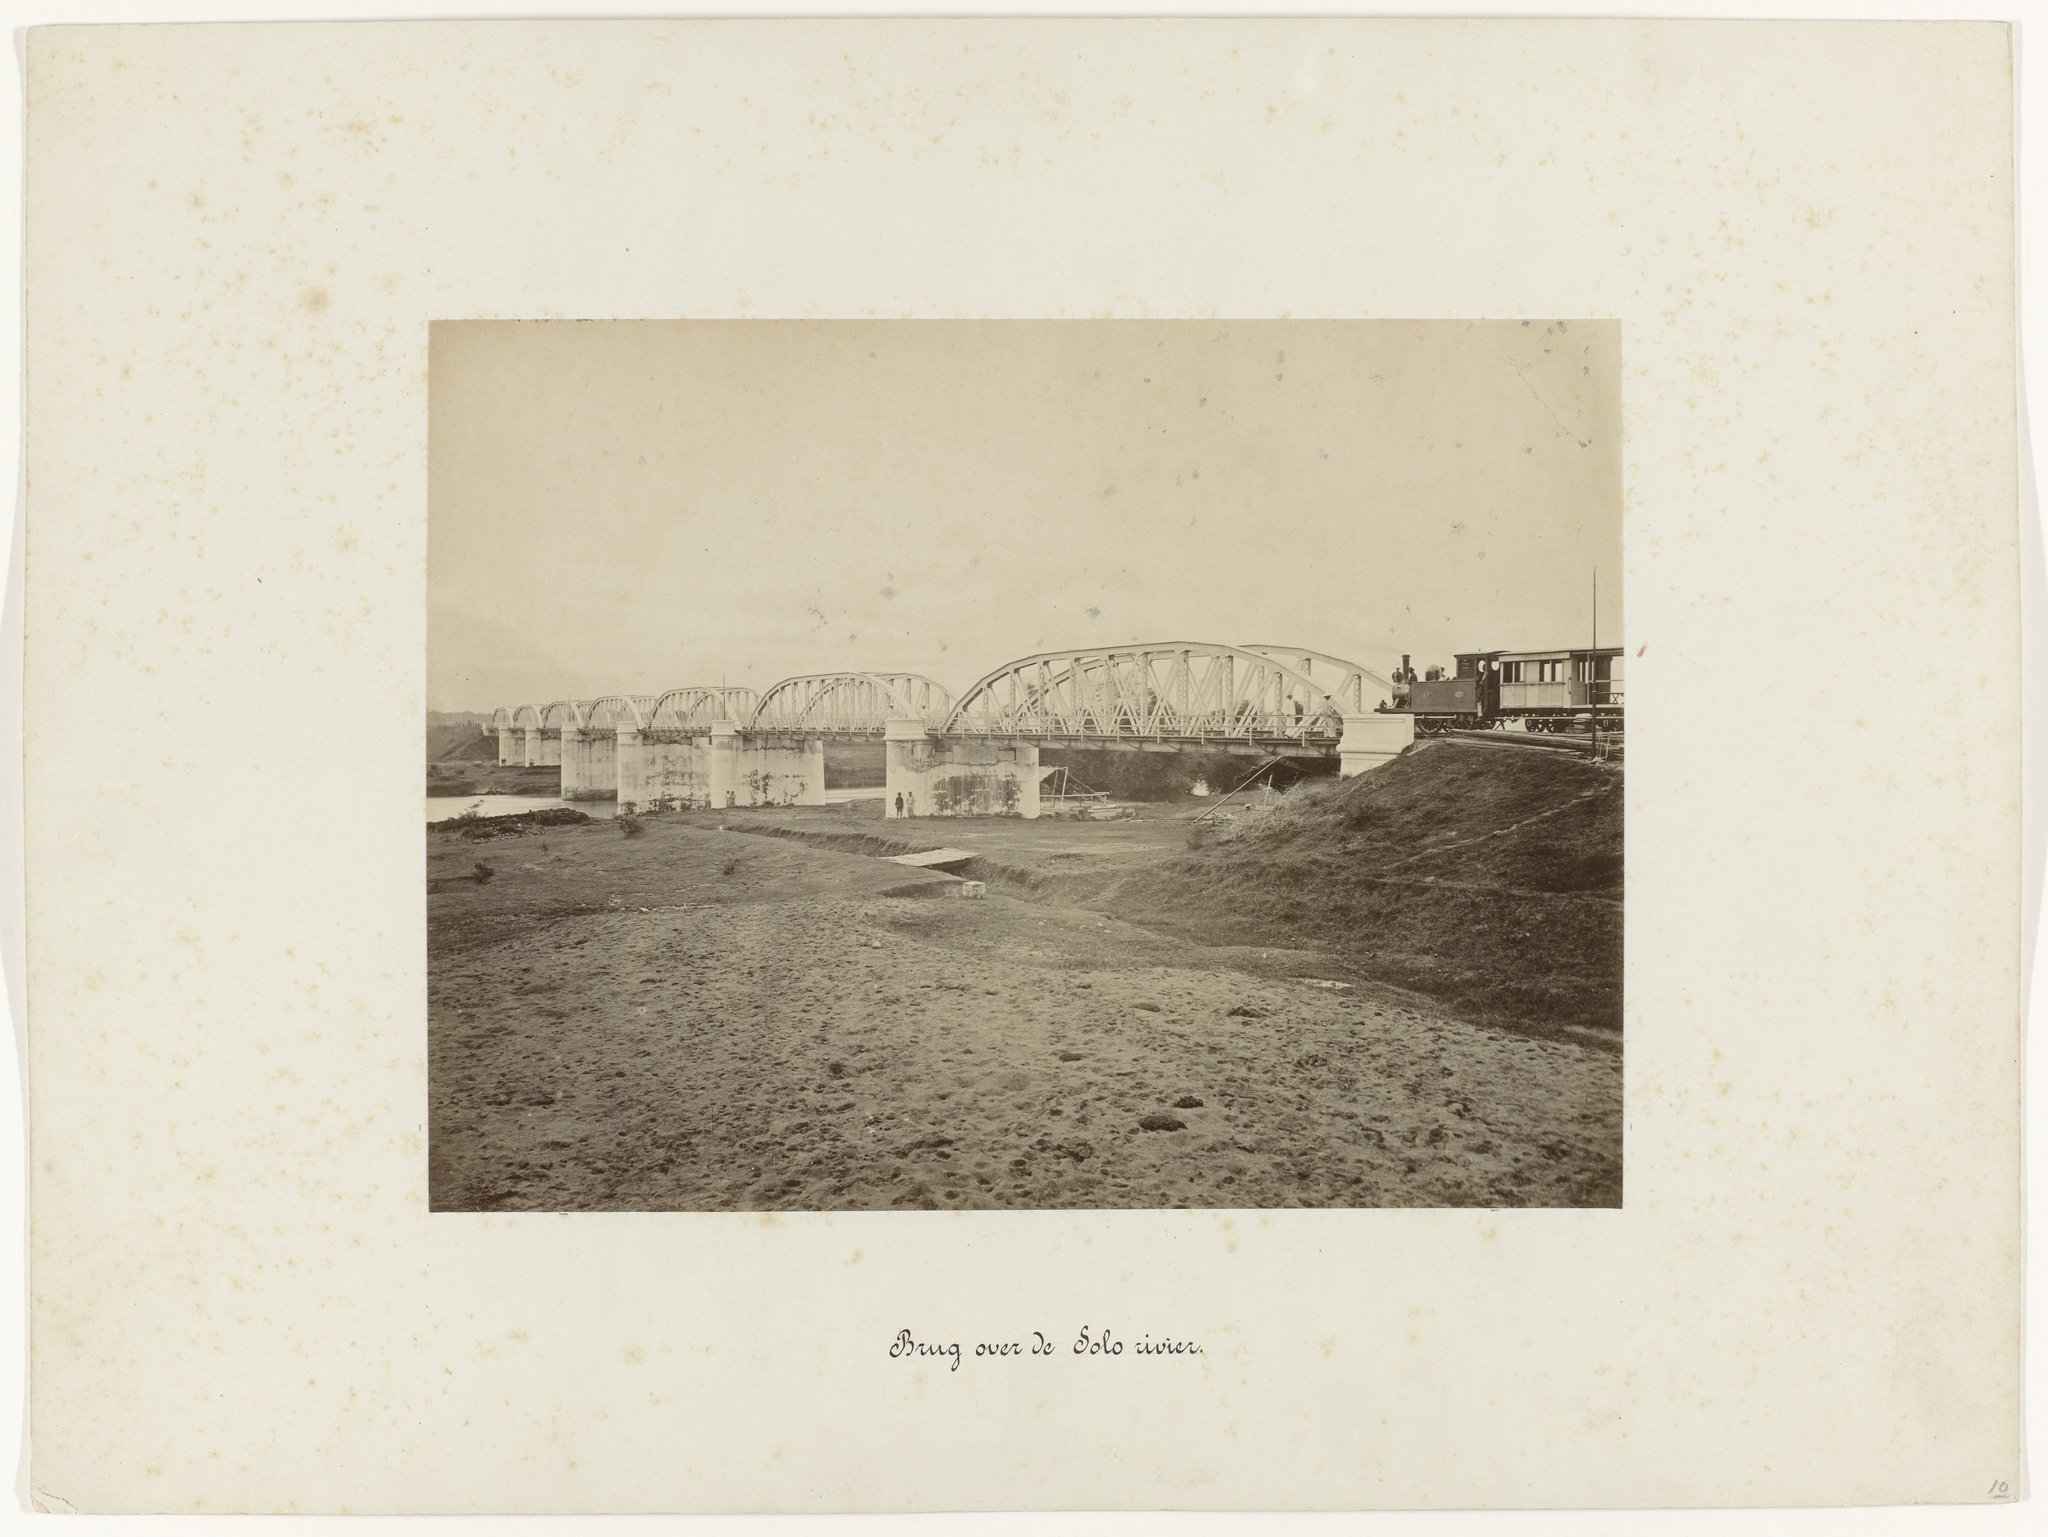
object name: photograph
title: Brug over de Solo-rivier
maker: Anonymous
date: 1880-1888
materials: photographic support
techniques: albumen print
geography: java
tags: solo-rivier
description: Gezicht op de brug over de Solo-rivier. Op het spoor voor de brug wacht een trein. Onderdeel van een groep van 62 foto's in een doos met het opschrift "Staatsspoorwegen op Java" uit 1888.